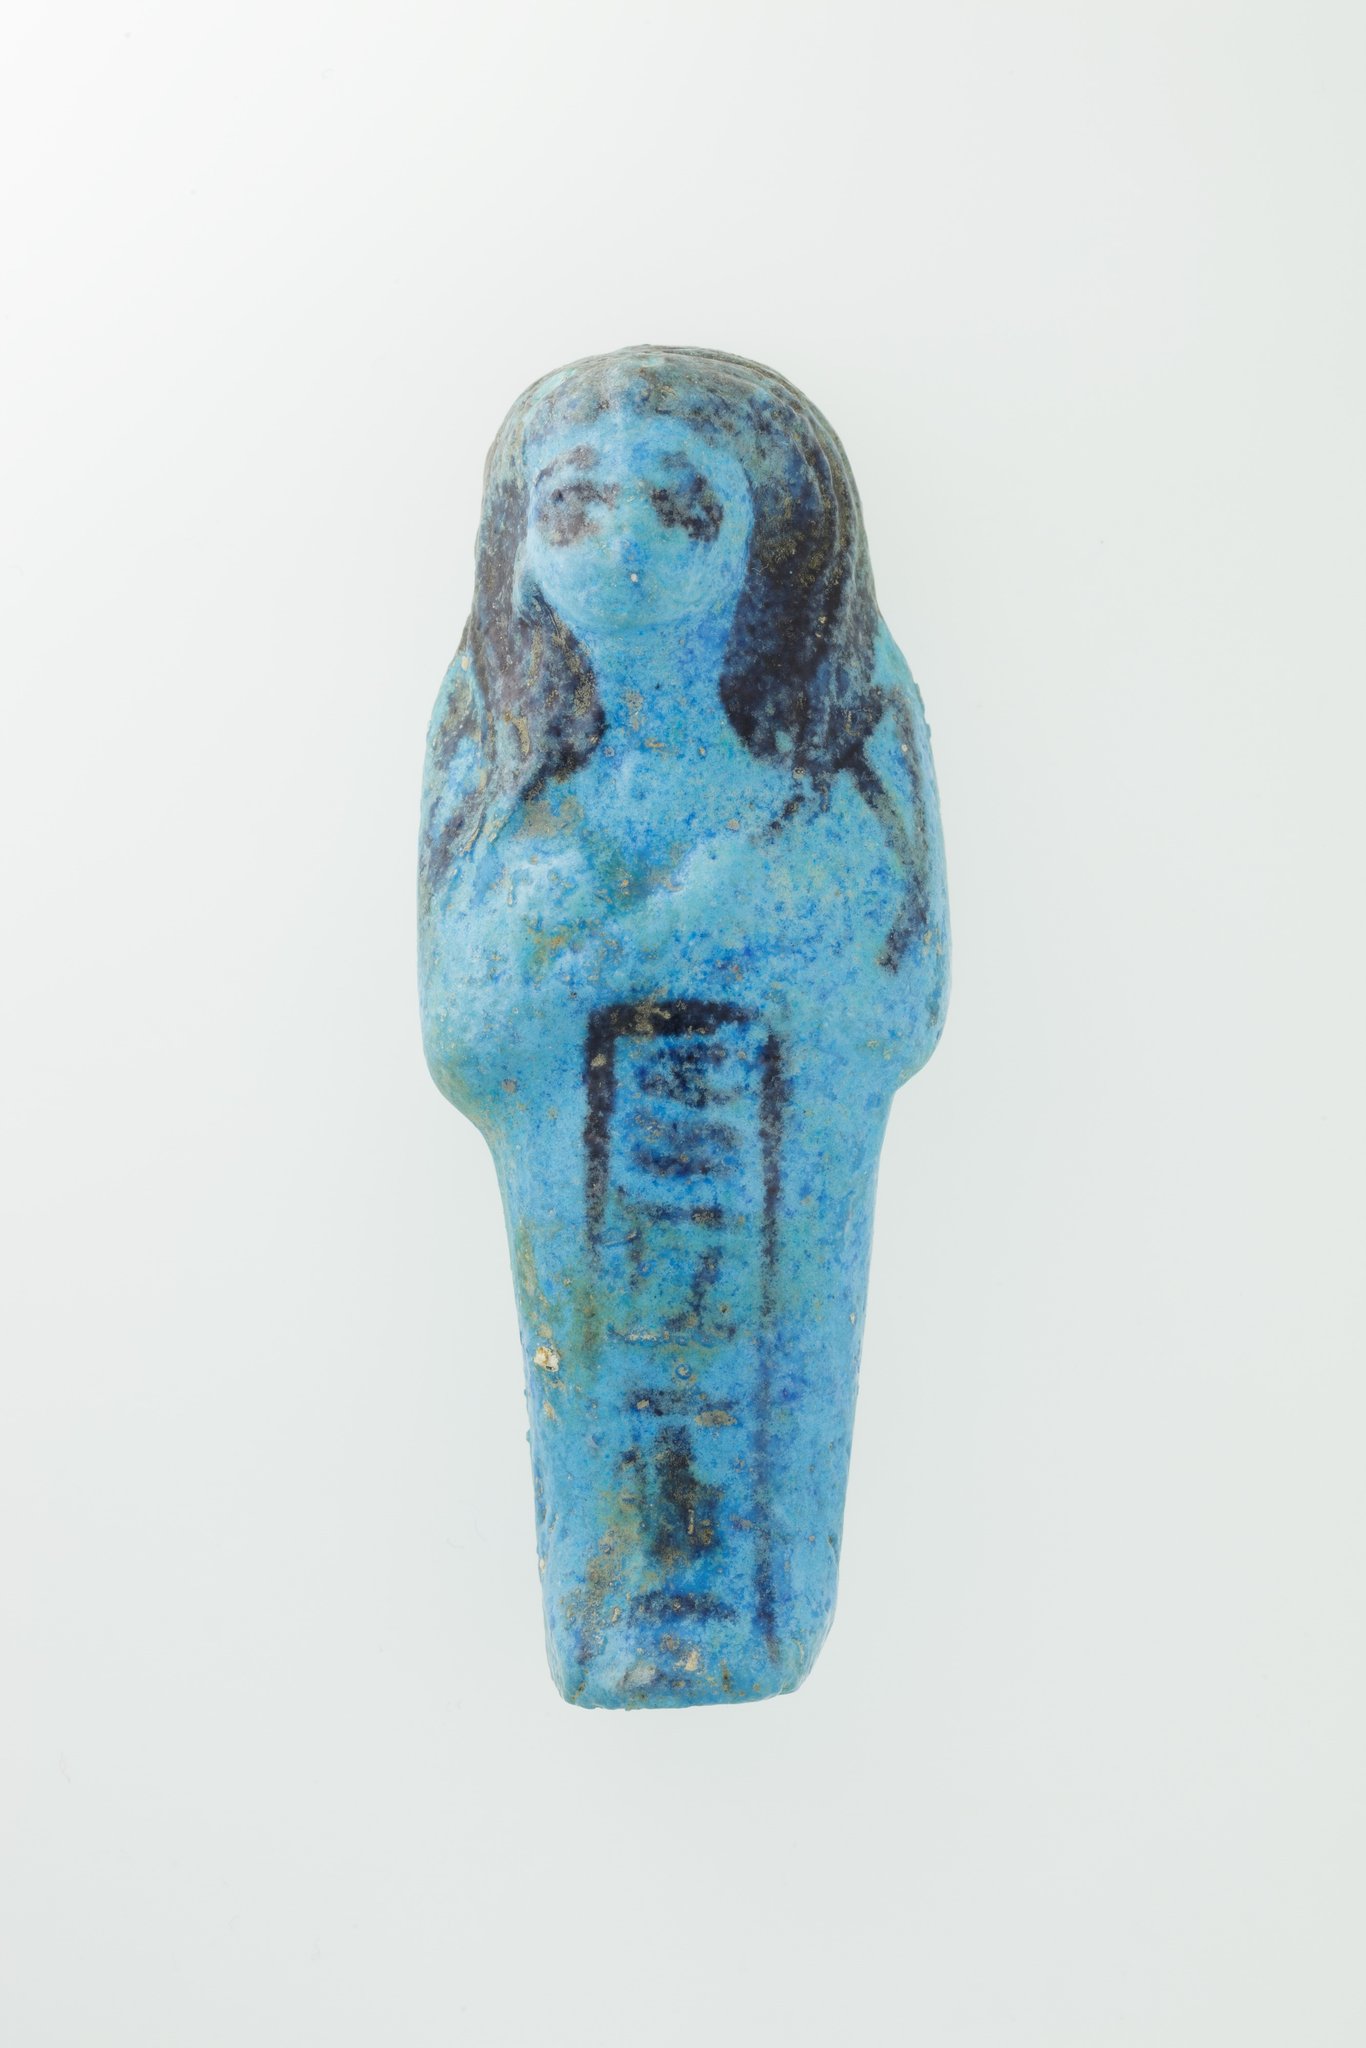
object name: shabti, worker, nauny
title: Worker Shabti of Nauny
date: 1050 BCE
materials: faience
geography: egypt